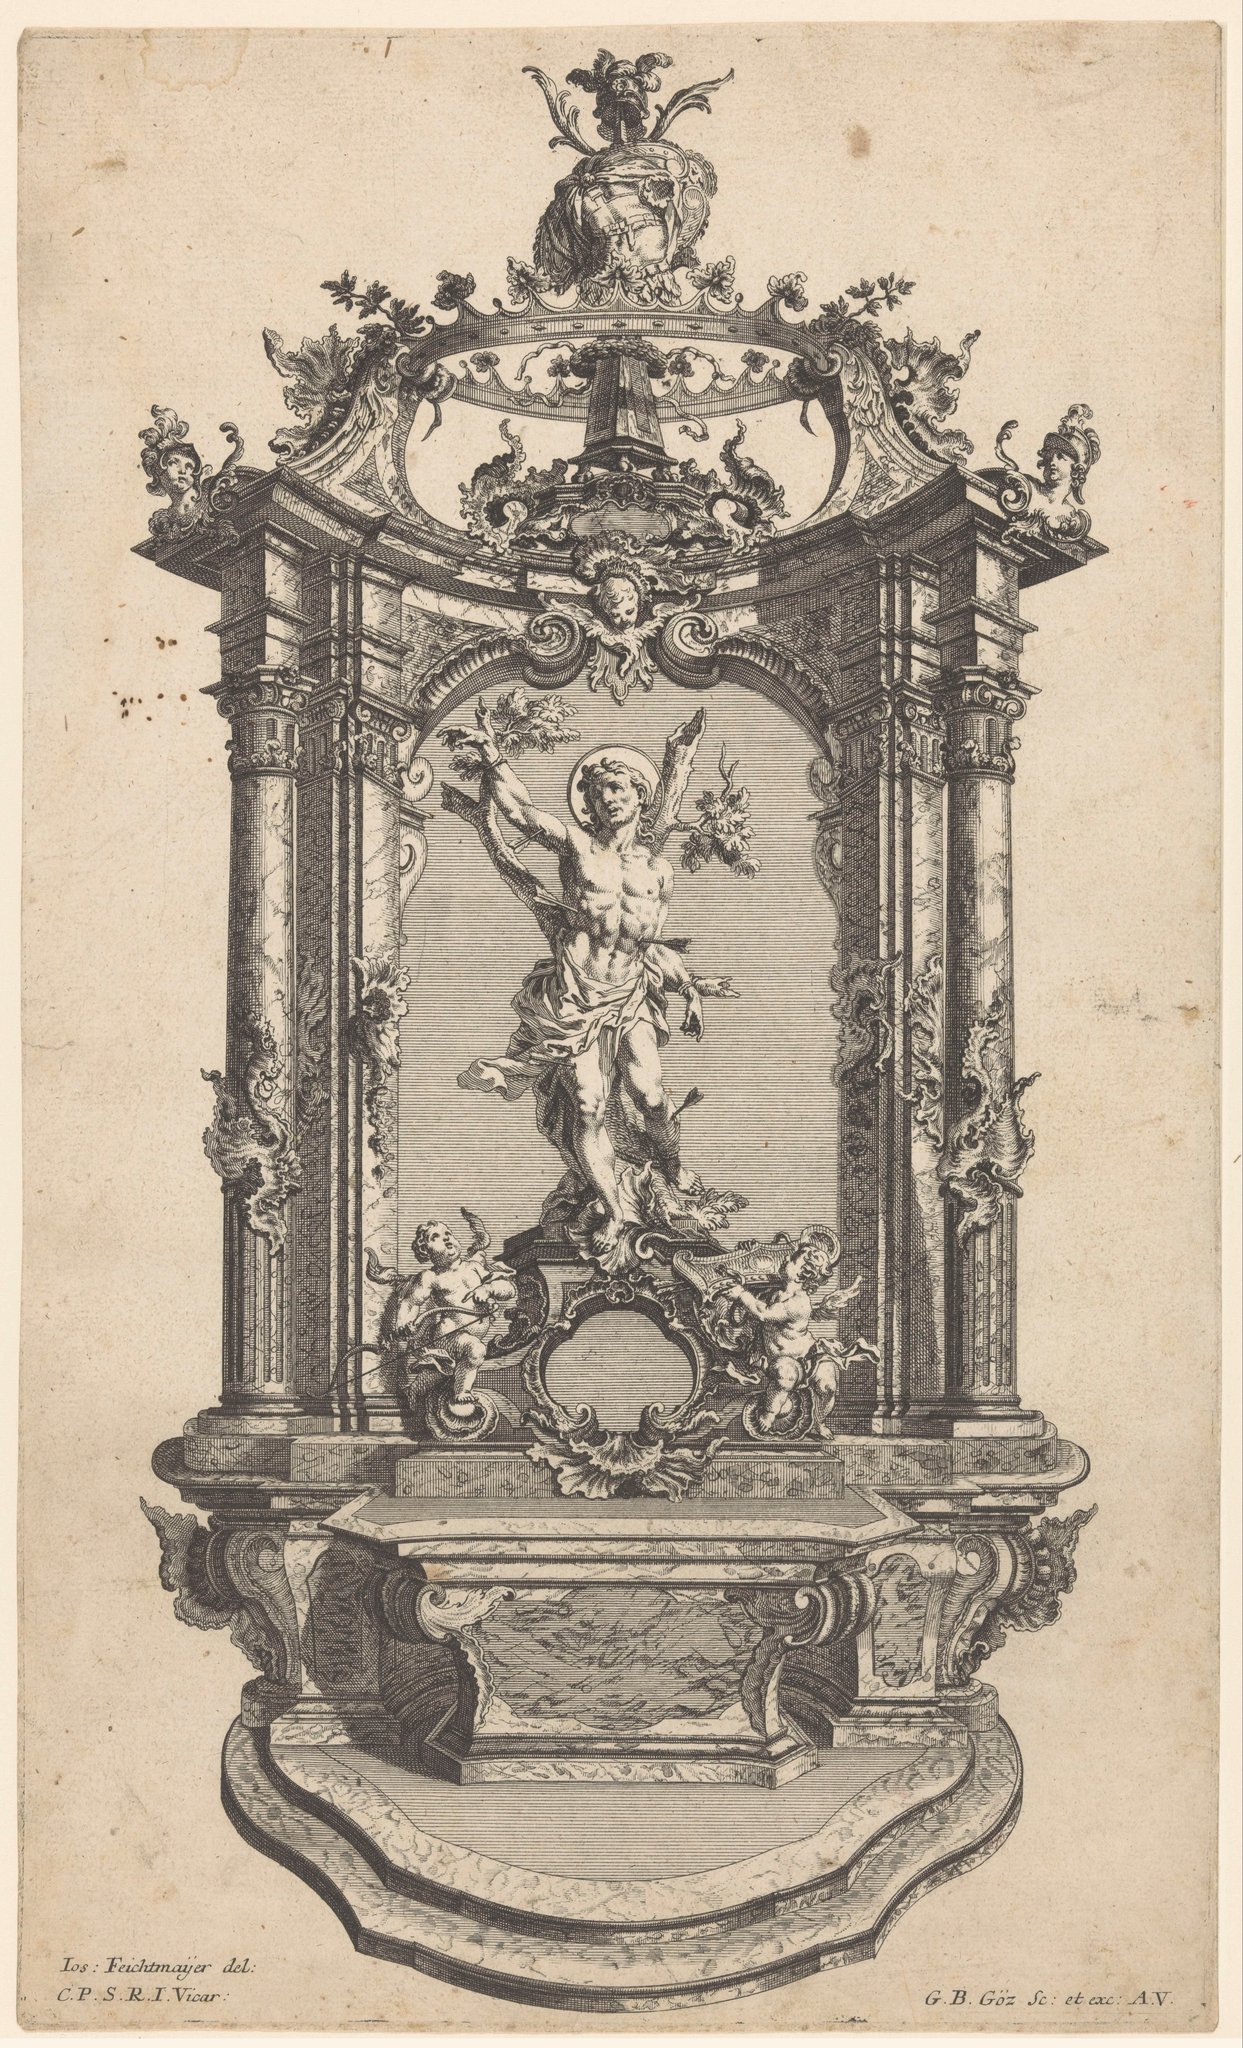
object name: ornament print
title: Altaar met H. Sebastiaan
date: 1740-1745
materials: paper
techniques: engraving, etching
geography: augsburg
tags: st. sebastian, tied to a tree or a pillar, is pierced by arrows, altar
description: De heilige Sebastiaan en twee engelen op een altaar met rocaille ornamenten. Aan de bovenzijde een harnas.